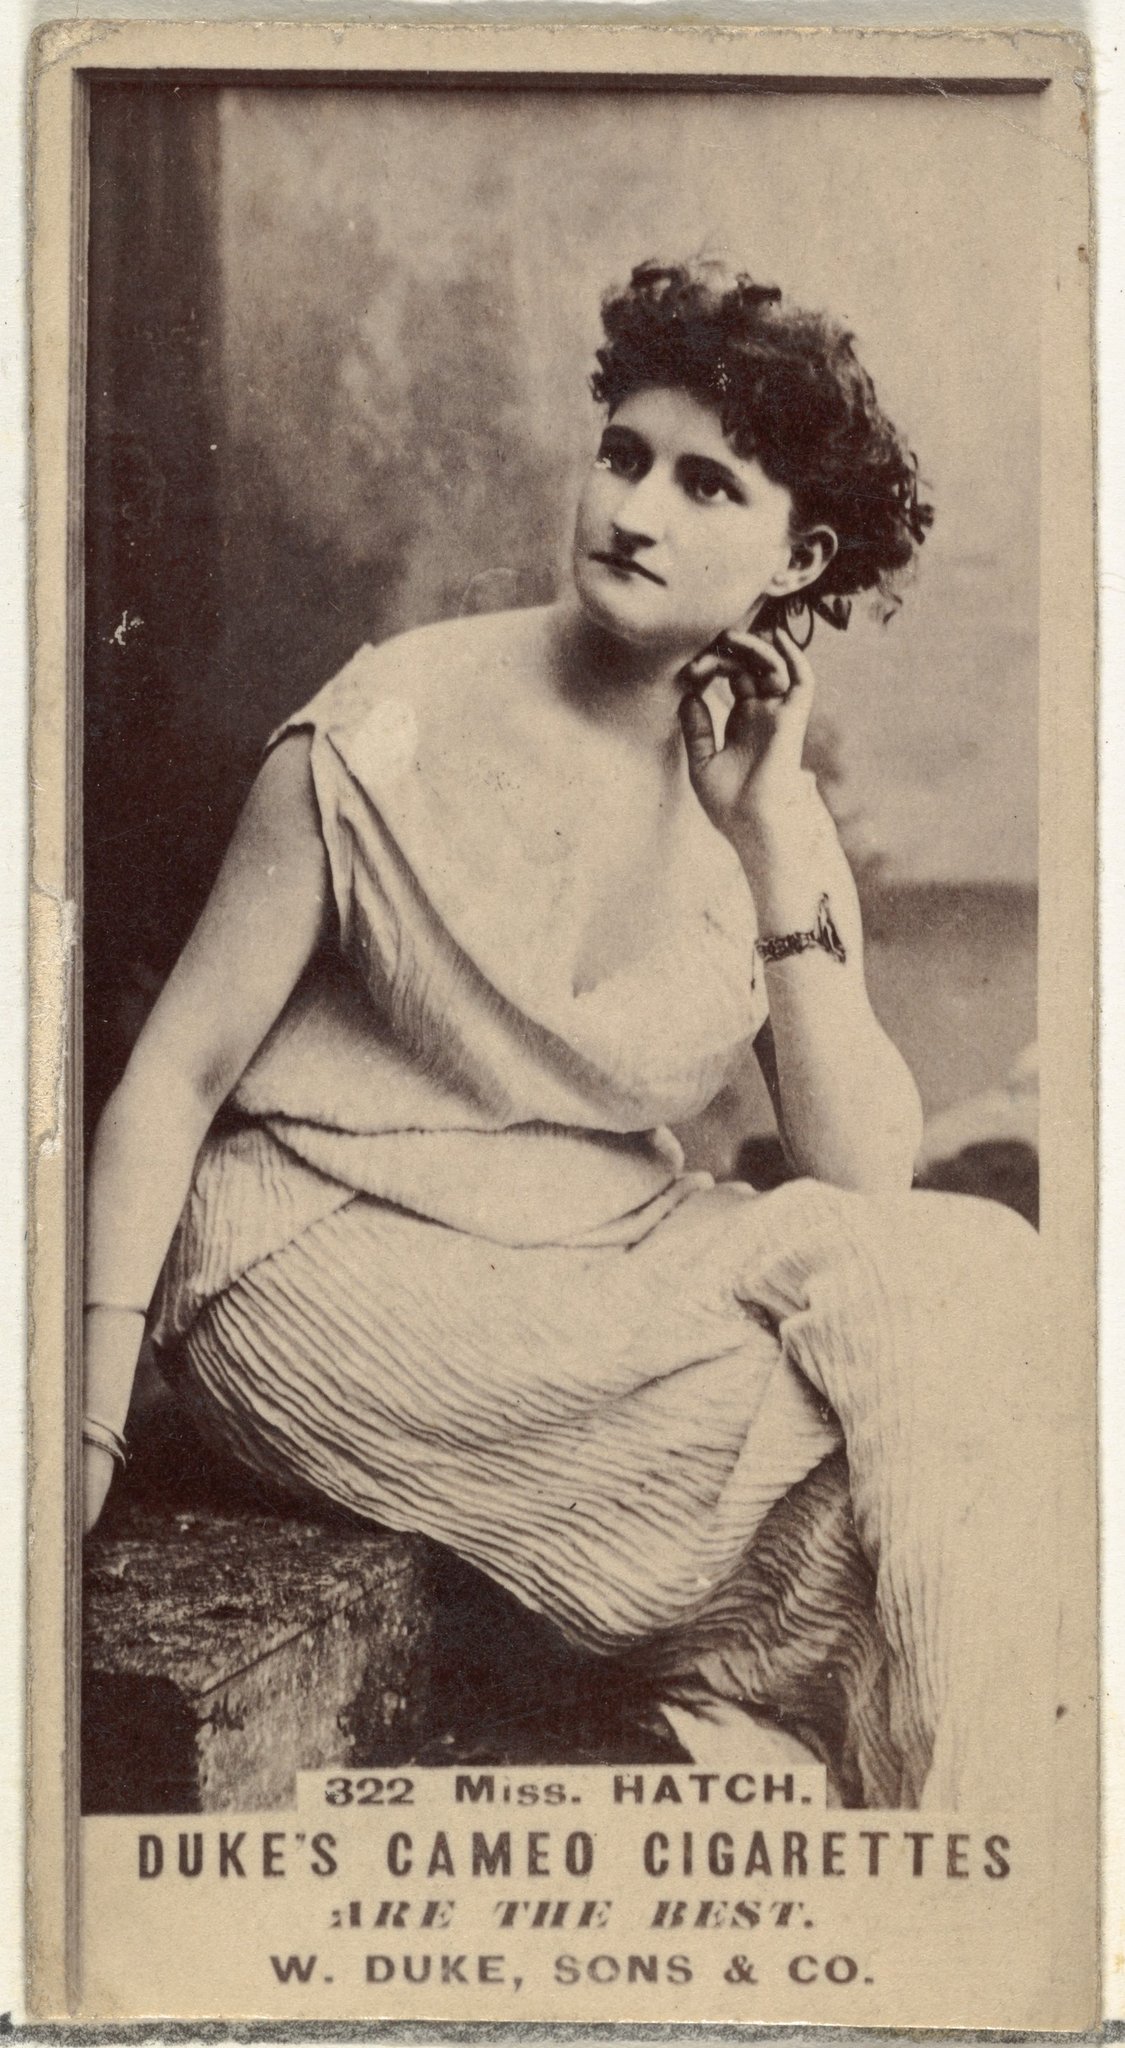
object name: photograph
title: Card Number 322, Miss Hatch, from the Actors and Actresses series (N145-5) issued by Duke Sons & Co. to promote Cameo Cigarettes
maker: w. duke, sons & co.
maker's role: publisher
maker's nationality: american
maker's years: 1870-1920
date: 1880-1889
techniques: albumen silver print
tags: portraits,women,actresses